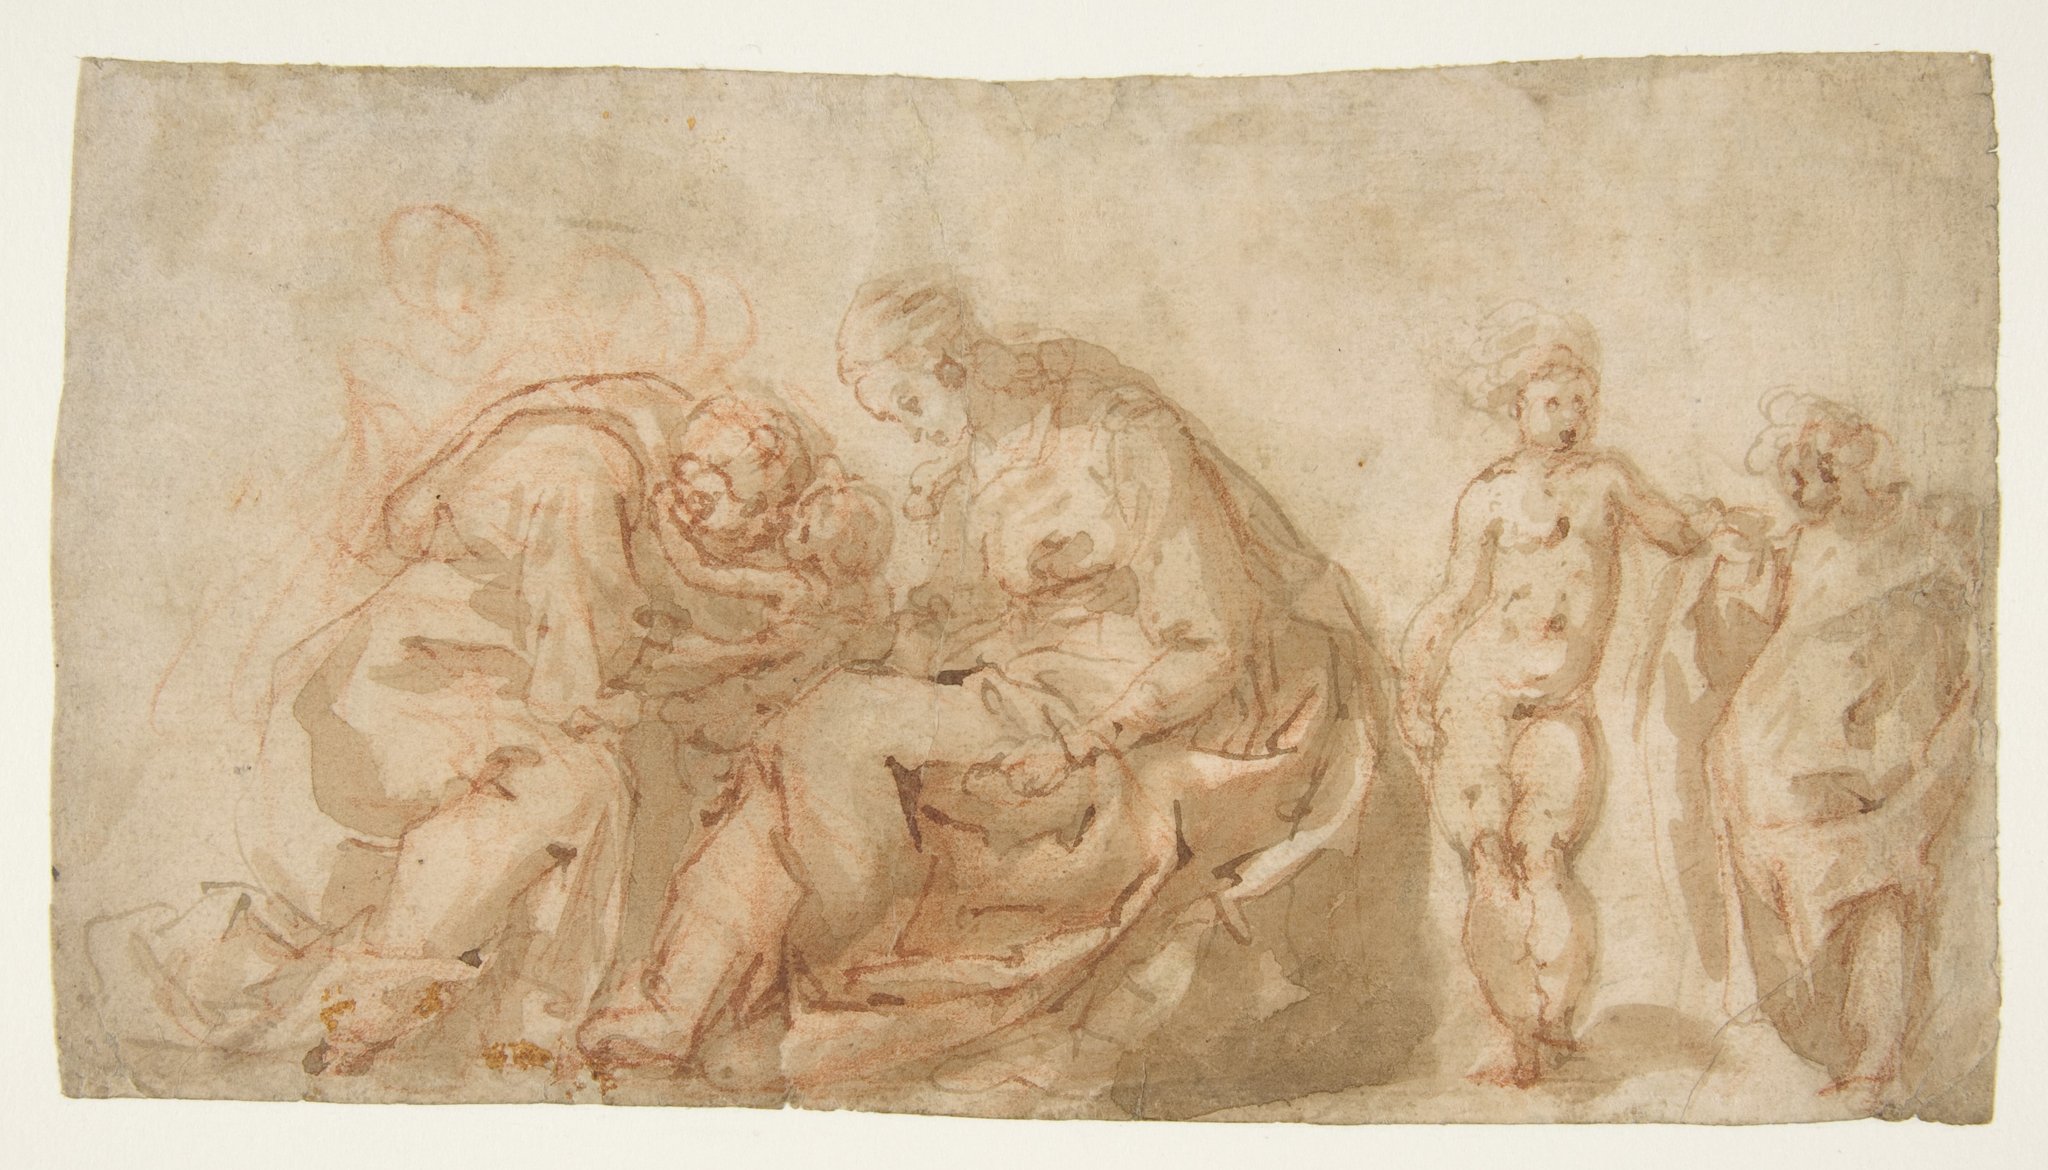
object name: drawing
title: The Holy Family with Attendant Putti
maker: cesare pollino (cesare dal francia or franchi)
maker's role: artist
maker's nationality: italian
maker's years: 1555-1598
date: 1560-1630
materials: chalk, ink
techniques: brush, pen, wash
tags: men,women,holy family